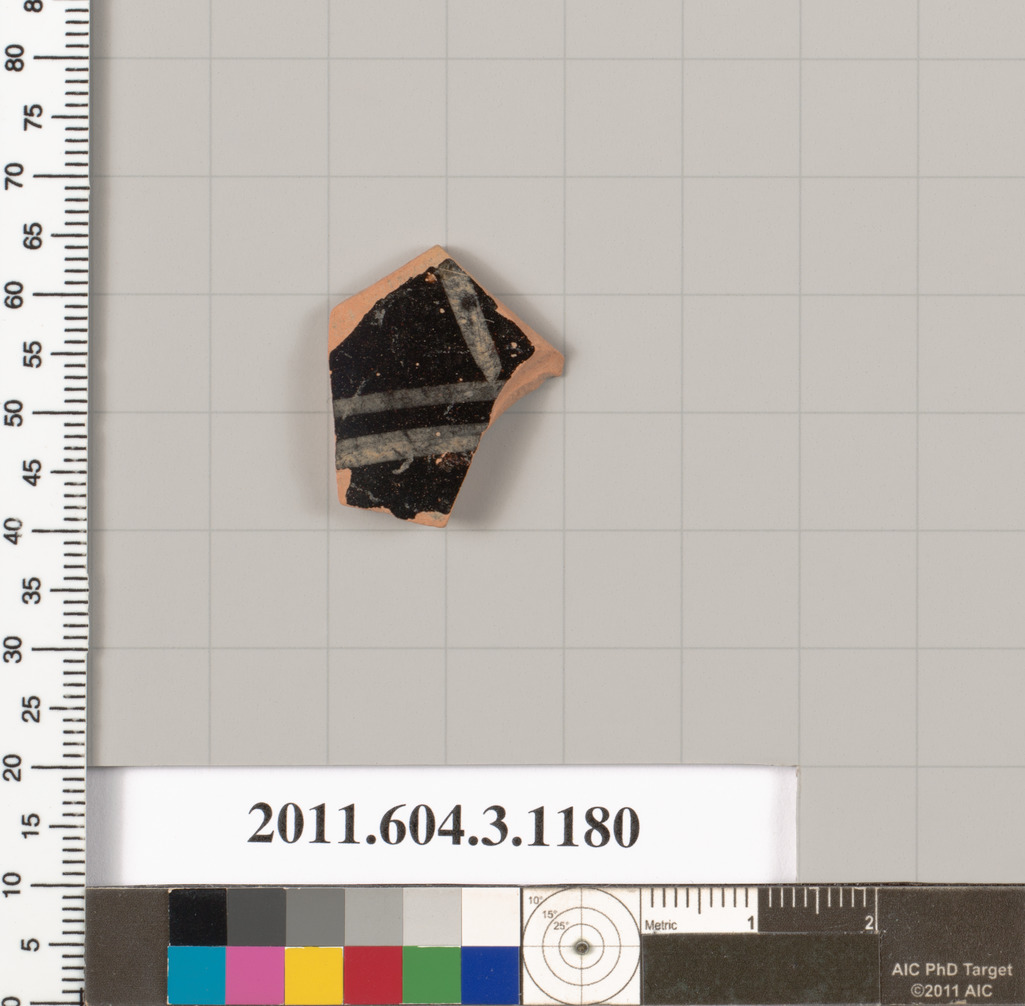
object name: mastoid or kyathos fragment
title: Terracotta fragment of a mastoid (drinking cup with narrow base) or a kyathos (cup-shaped ladle)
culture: greek, attic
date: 534-468 BCE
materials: terracotta